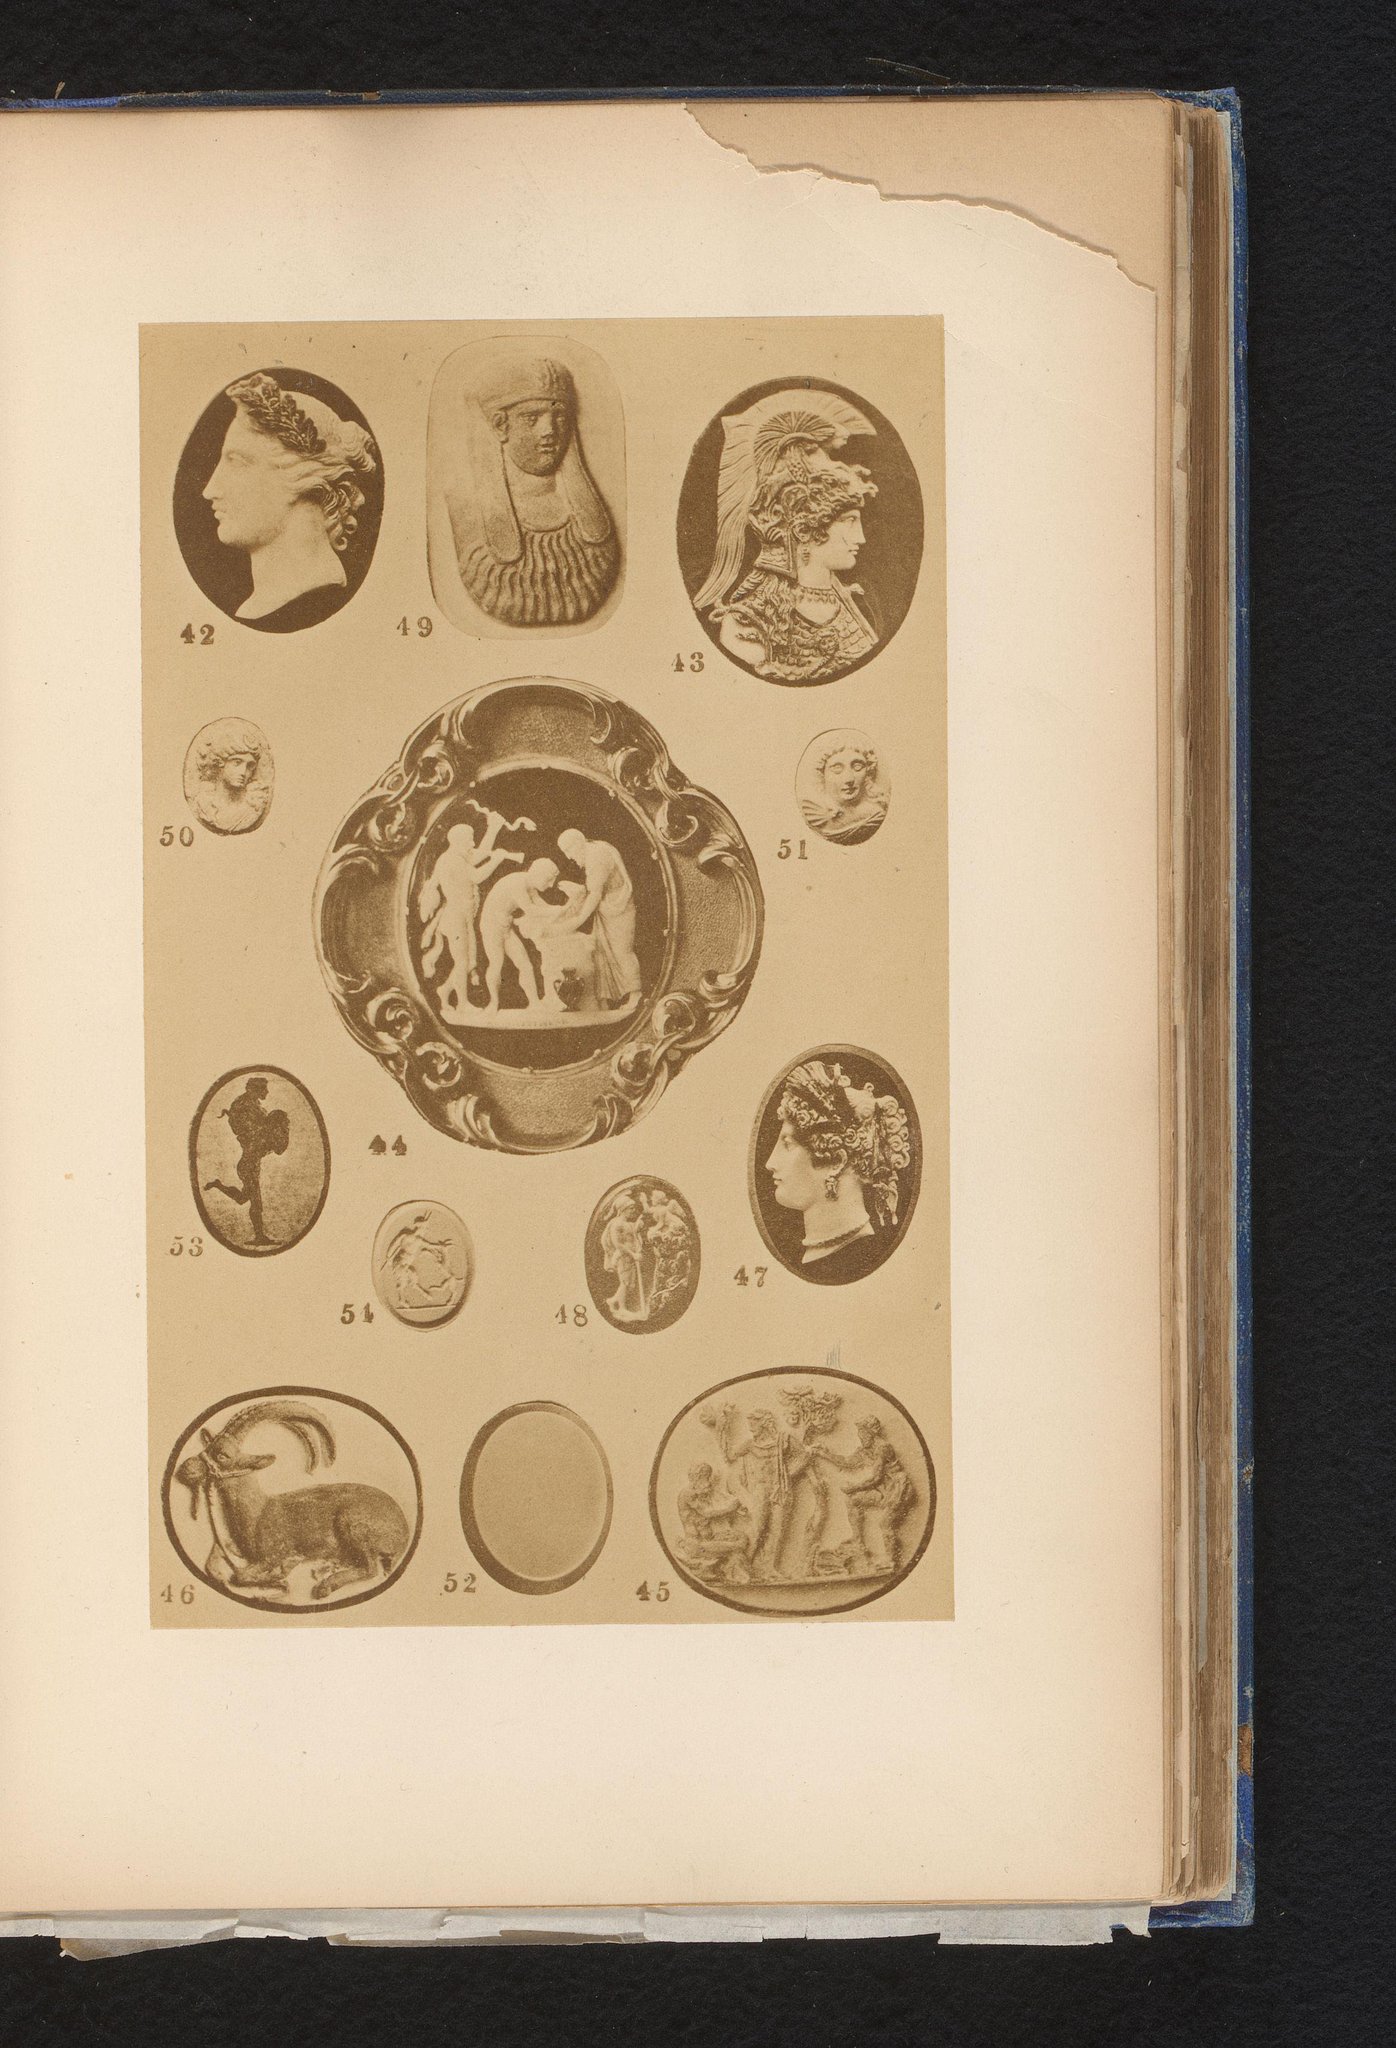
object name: page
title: Dertien cameeën en intaglia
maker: f. cole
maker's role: fotograaf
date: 1862-1867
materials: paper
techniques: albumen print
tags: carving ~ applied arts, historical persons (portraits and scenes from the life) (+ profile portrait), gem, gemstone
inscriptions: number: ‘42 - 54’